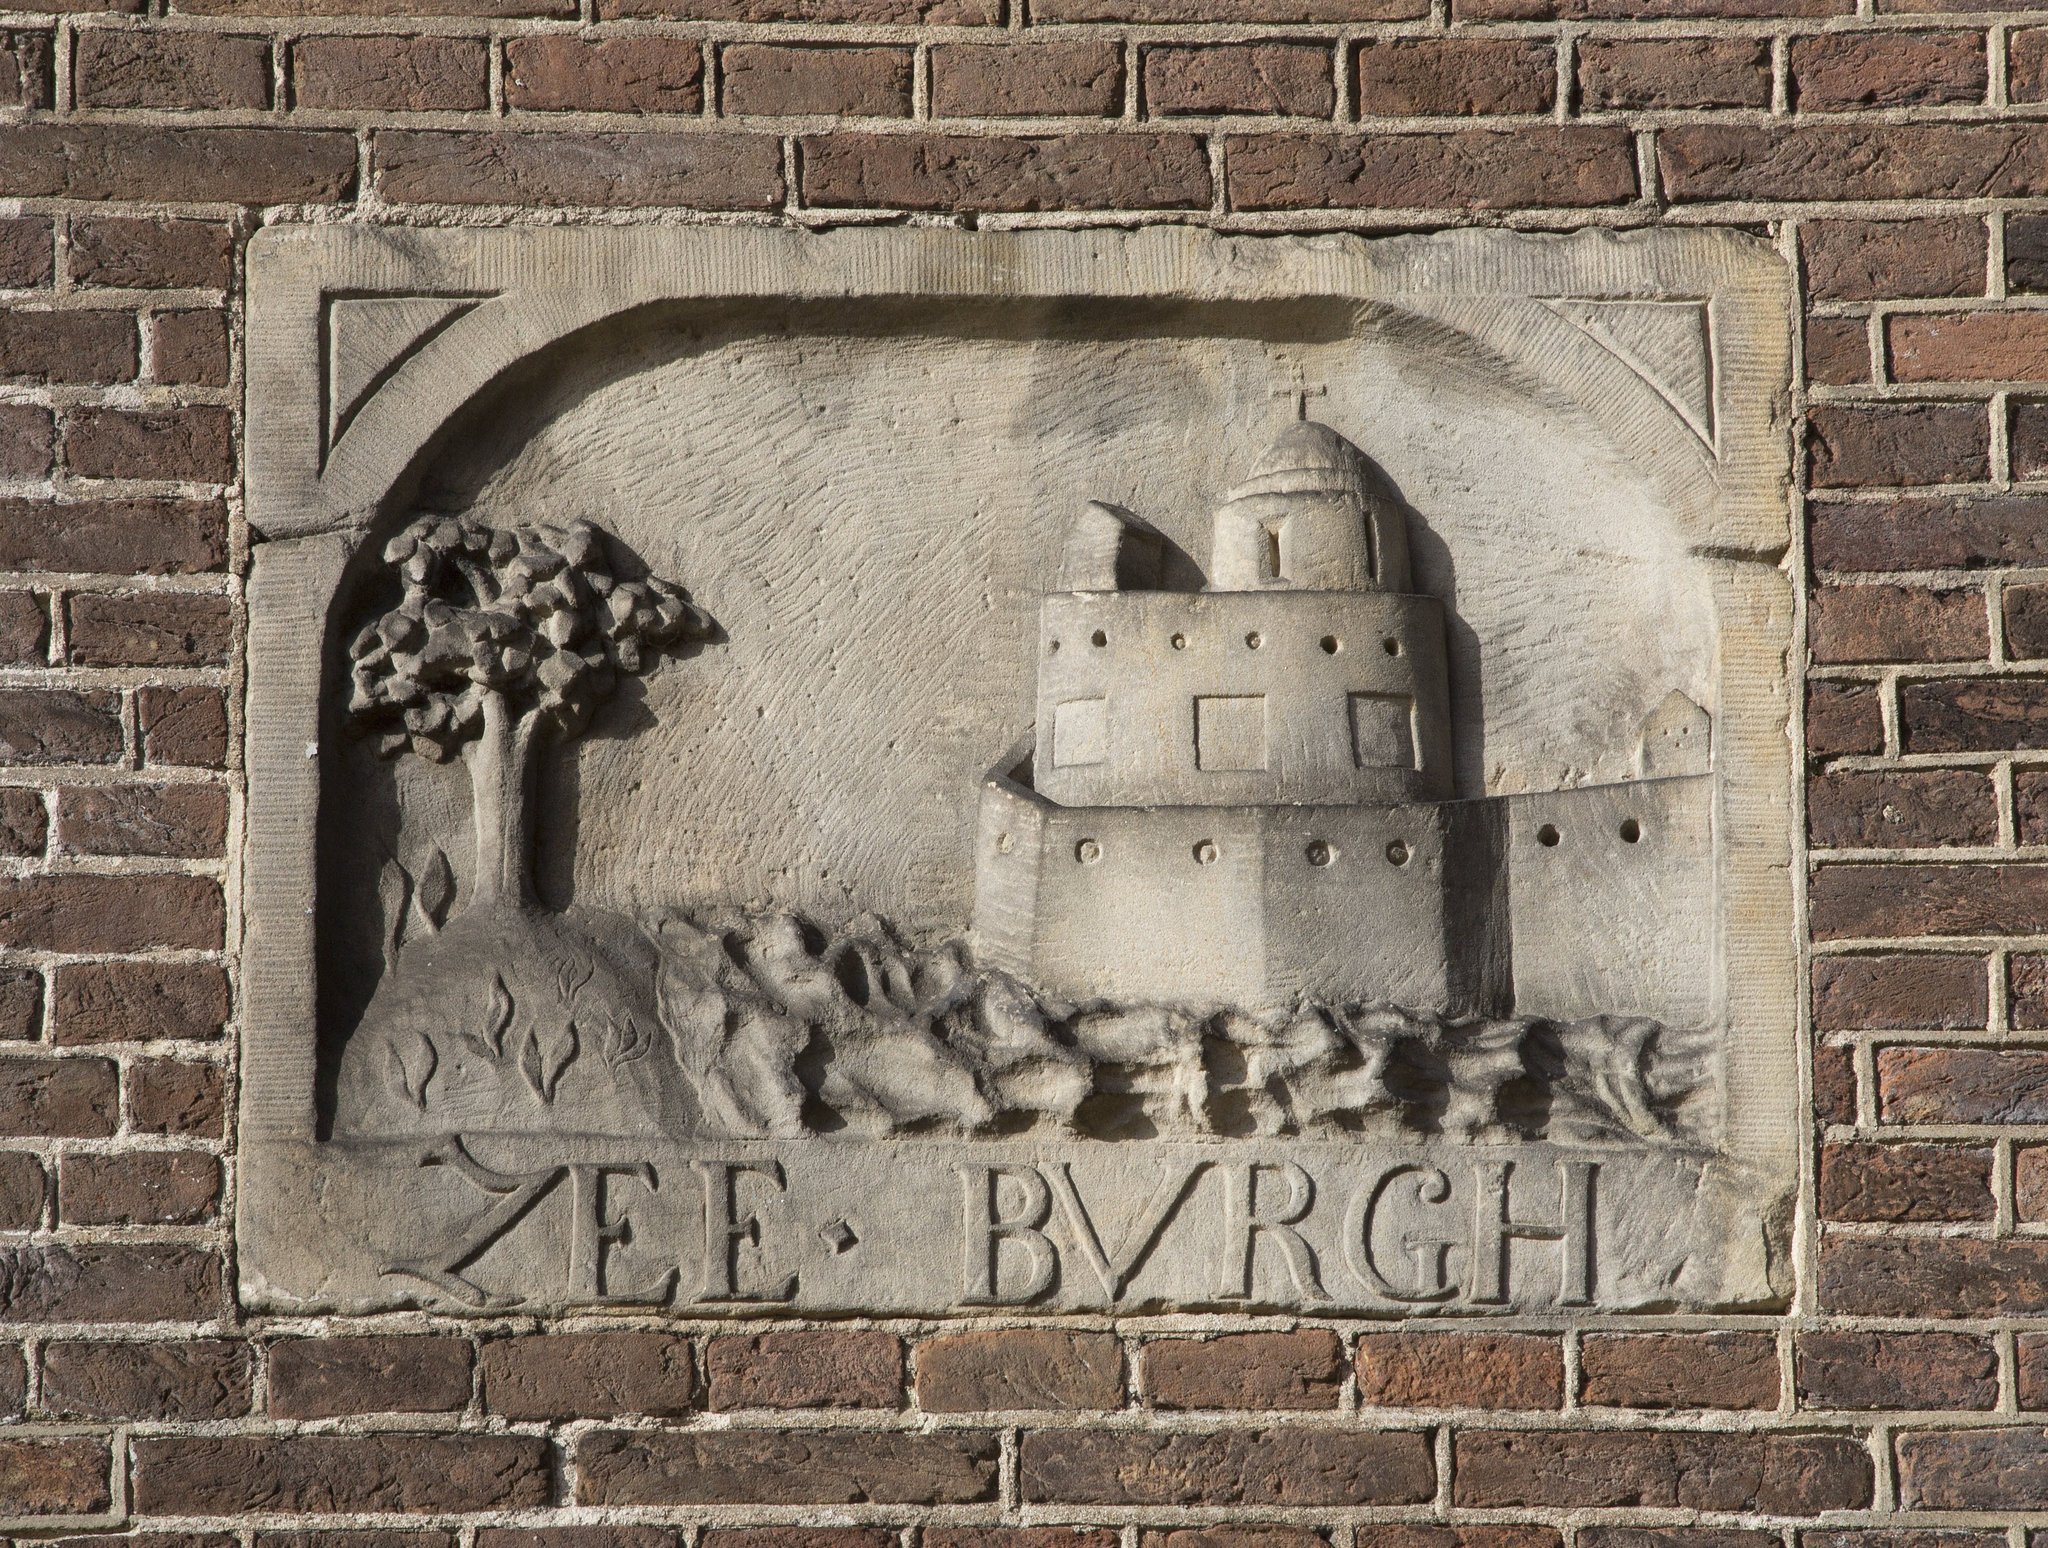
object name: gable stone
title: Gevelsteen met opschrift: ZEEBURGH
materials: stone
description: Een gevelsteen met opschrift: ZEE BURGH.